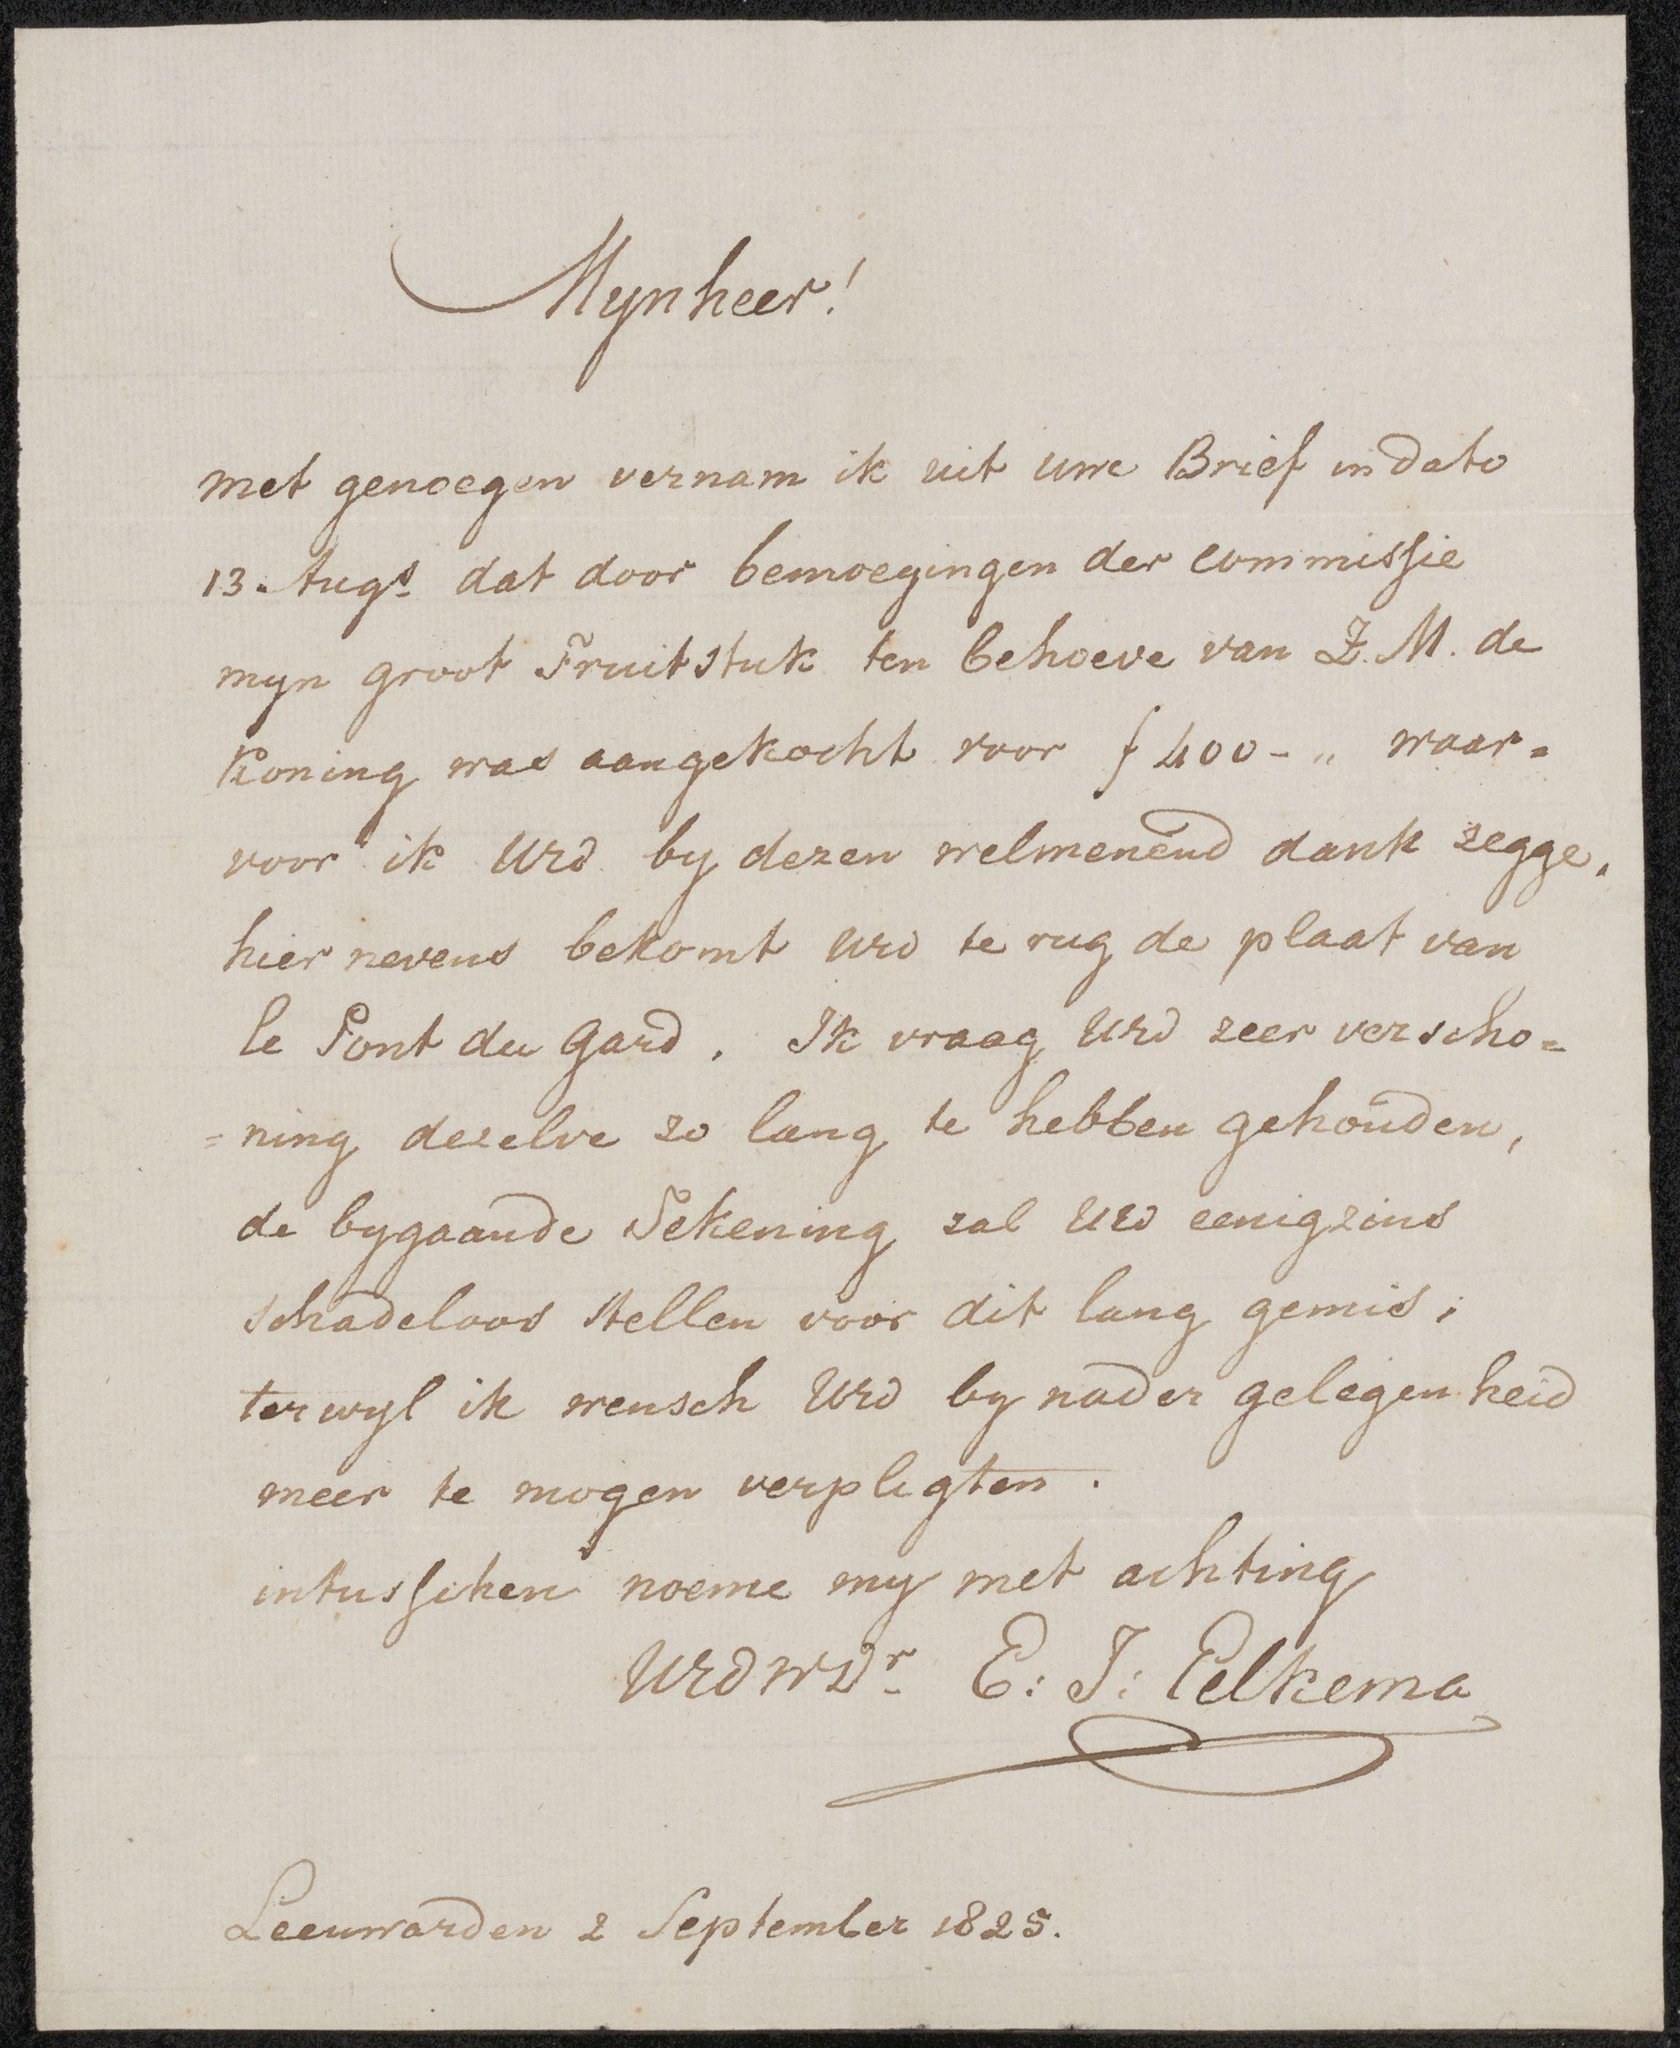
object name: letter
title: Brief aan anoniem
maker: eelke jelles eelkema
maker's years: 1788-1839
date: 1825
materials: ink, paper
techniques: pen, writing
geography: leeuwarden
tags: william i of the netherlands, painting (including book-illumination, miniature-painting), money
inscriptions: collector's mark: ‘RPK’